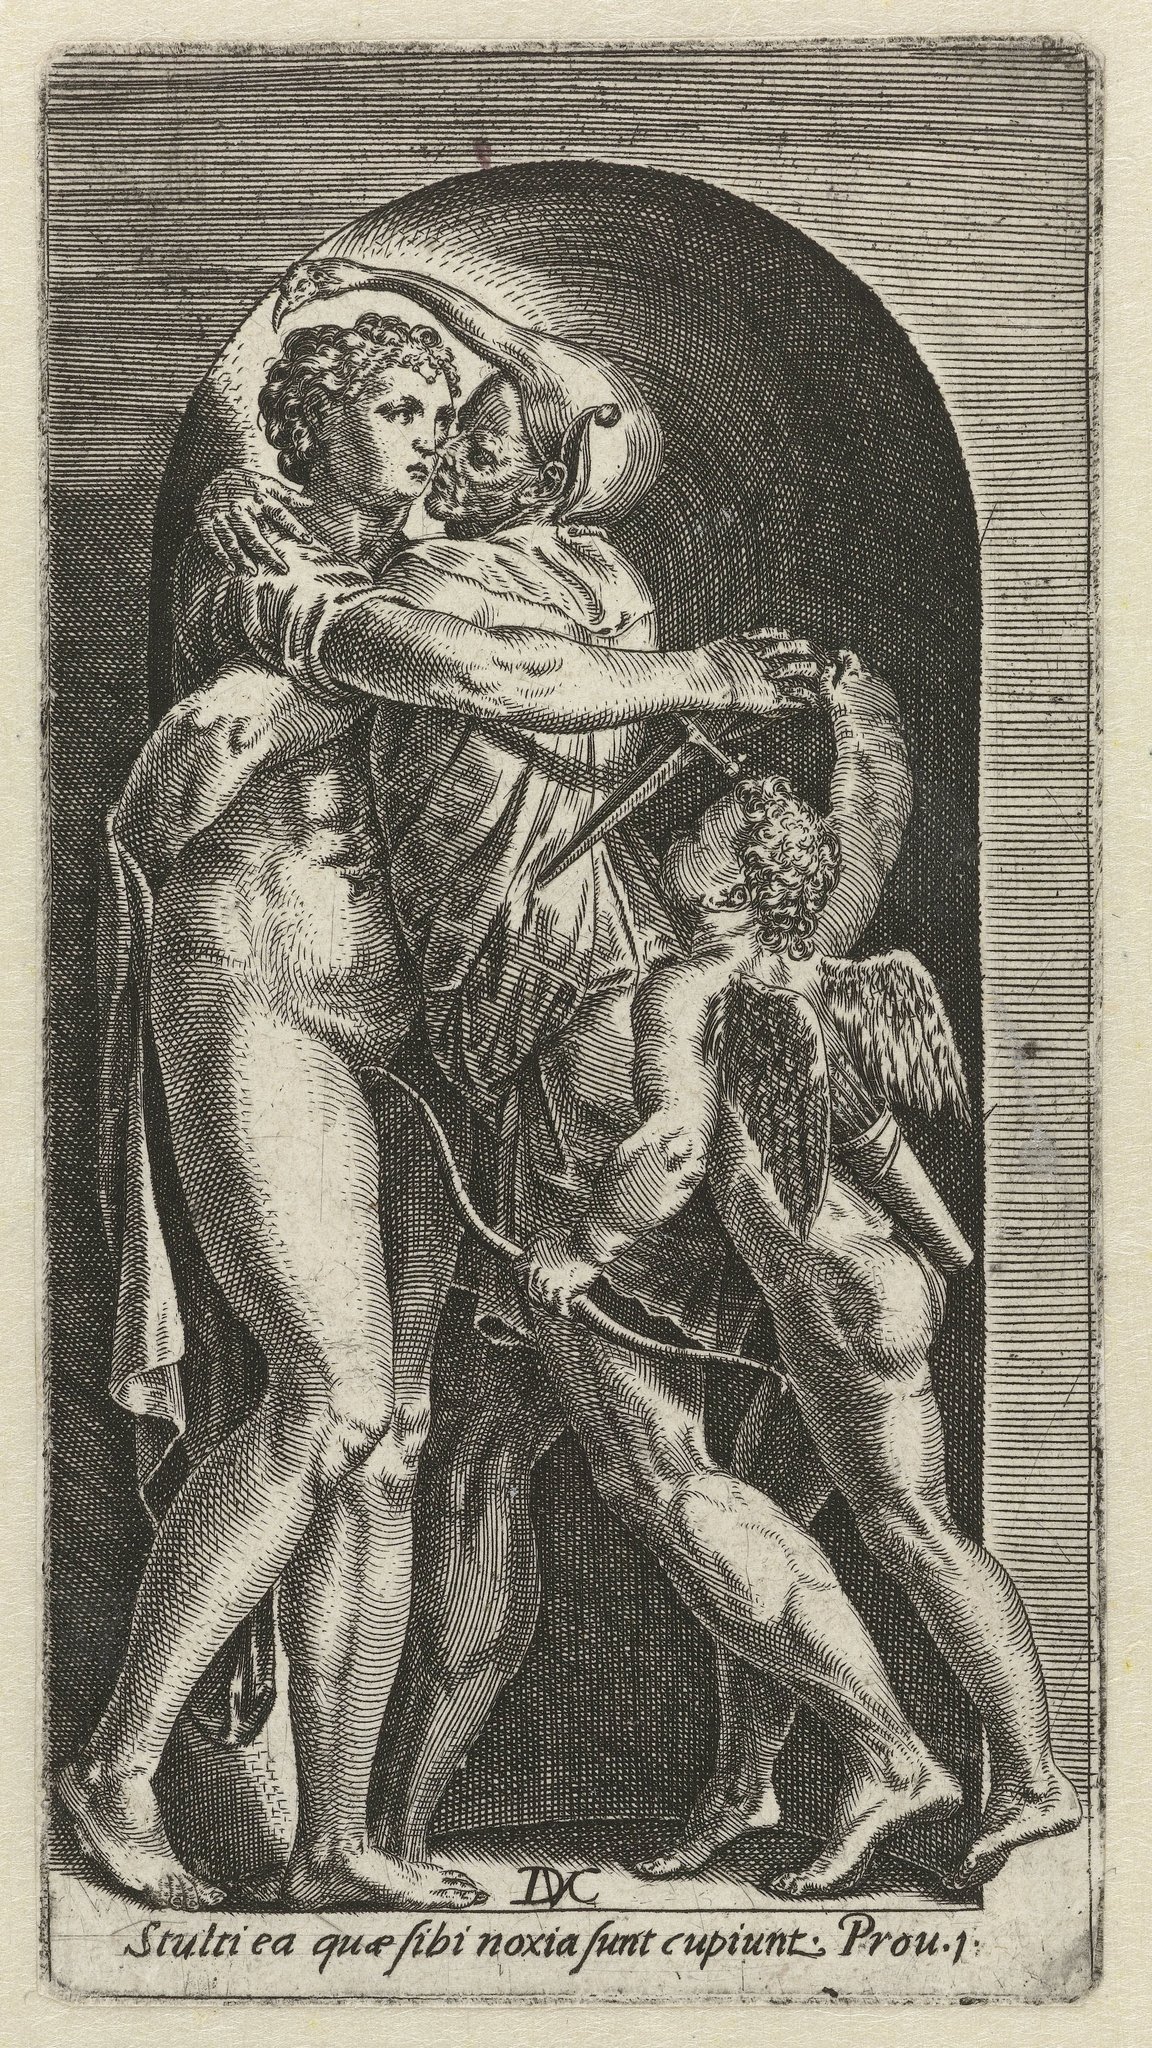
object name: print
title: Dwaasheid van lust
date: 1532-1590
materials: paper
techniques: engraving, etching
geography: haarlem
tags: lust, luxury, 'luxuria'; 'lussuria' (ripa) ~ personification of one of the deadly sins, fool, simpleton, numskull, hacking and thrusting weapons: dagger, venus and cupid (cupid not being mere attribute)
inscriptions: collector's mark: Lugt 2228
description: Een zot omarmt de naakte Lust (Venus?), onbewust van het feit dat de vrouw, met de hulp van Cupido, een dolk in zijn rug plant. De prent heeft een Latijns onderschrift dat waarschuwt voor de gevaren van zinnelijke begeerte.